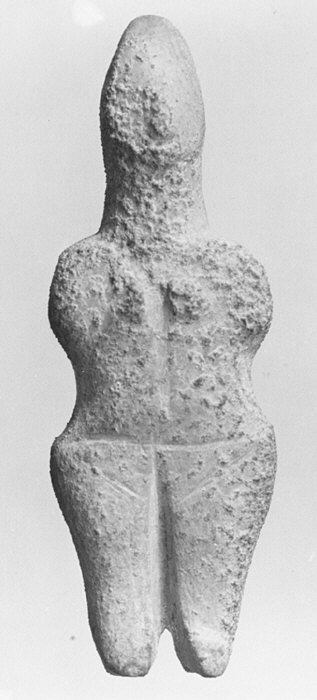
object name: statuette of a woman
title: Marble female figure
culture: cycladic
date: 3200-2700 BCE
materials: marble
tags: women